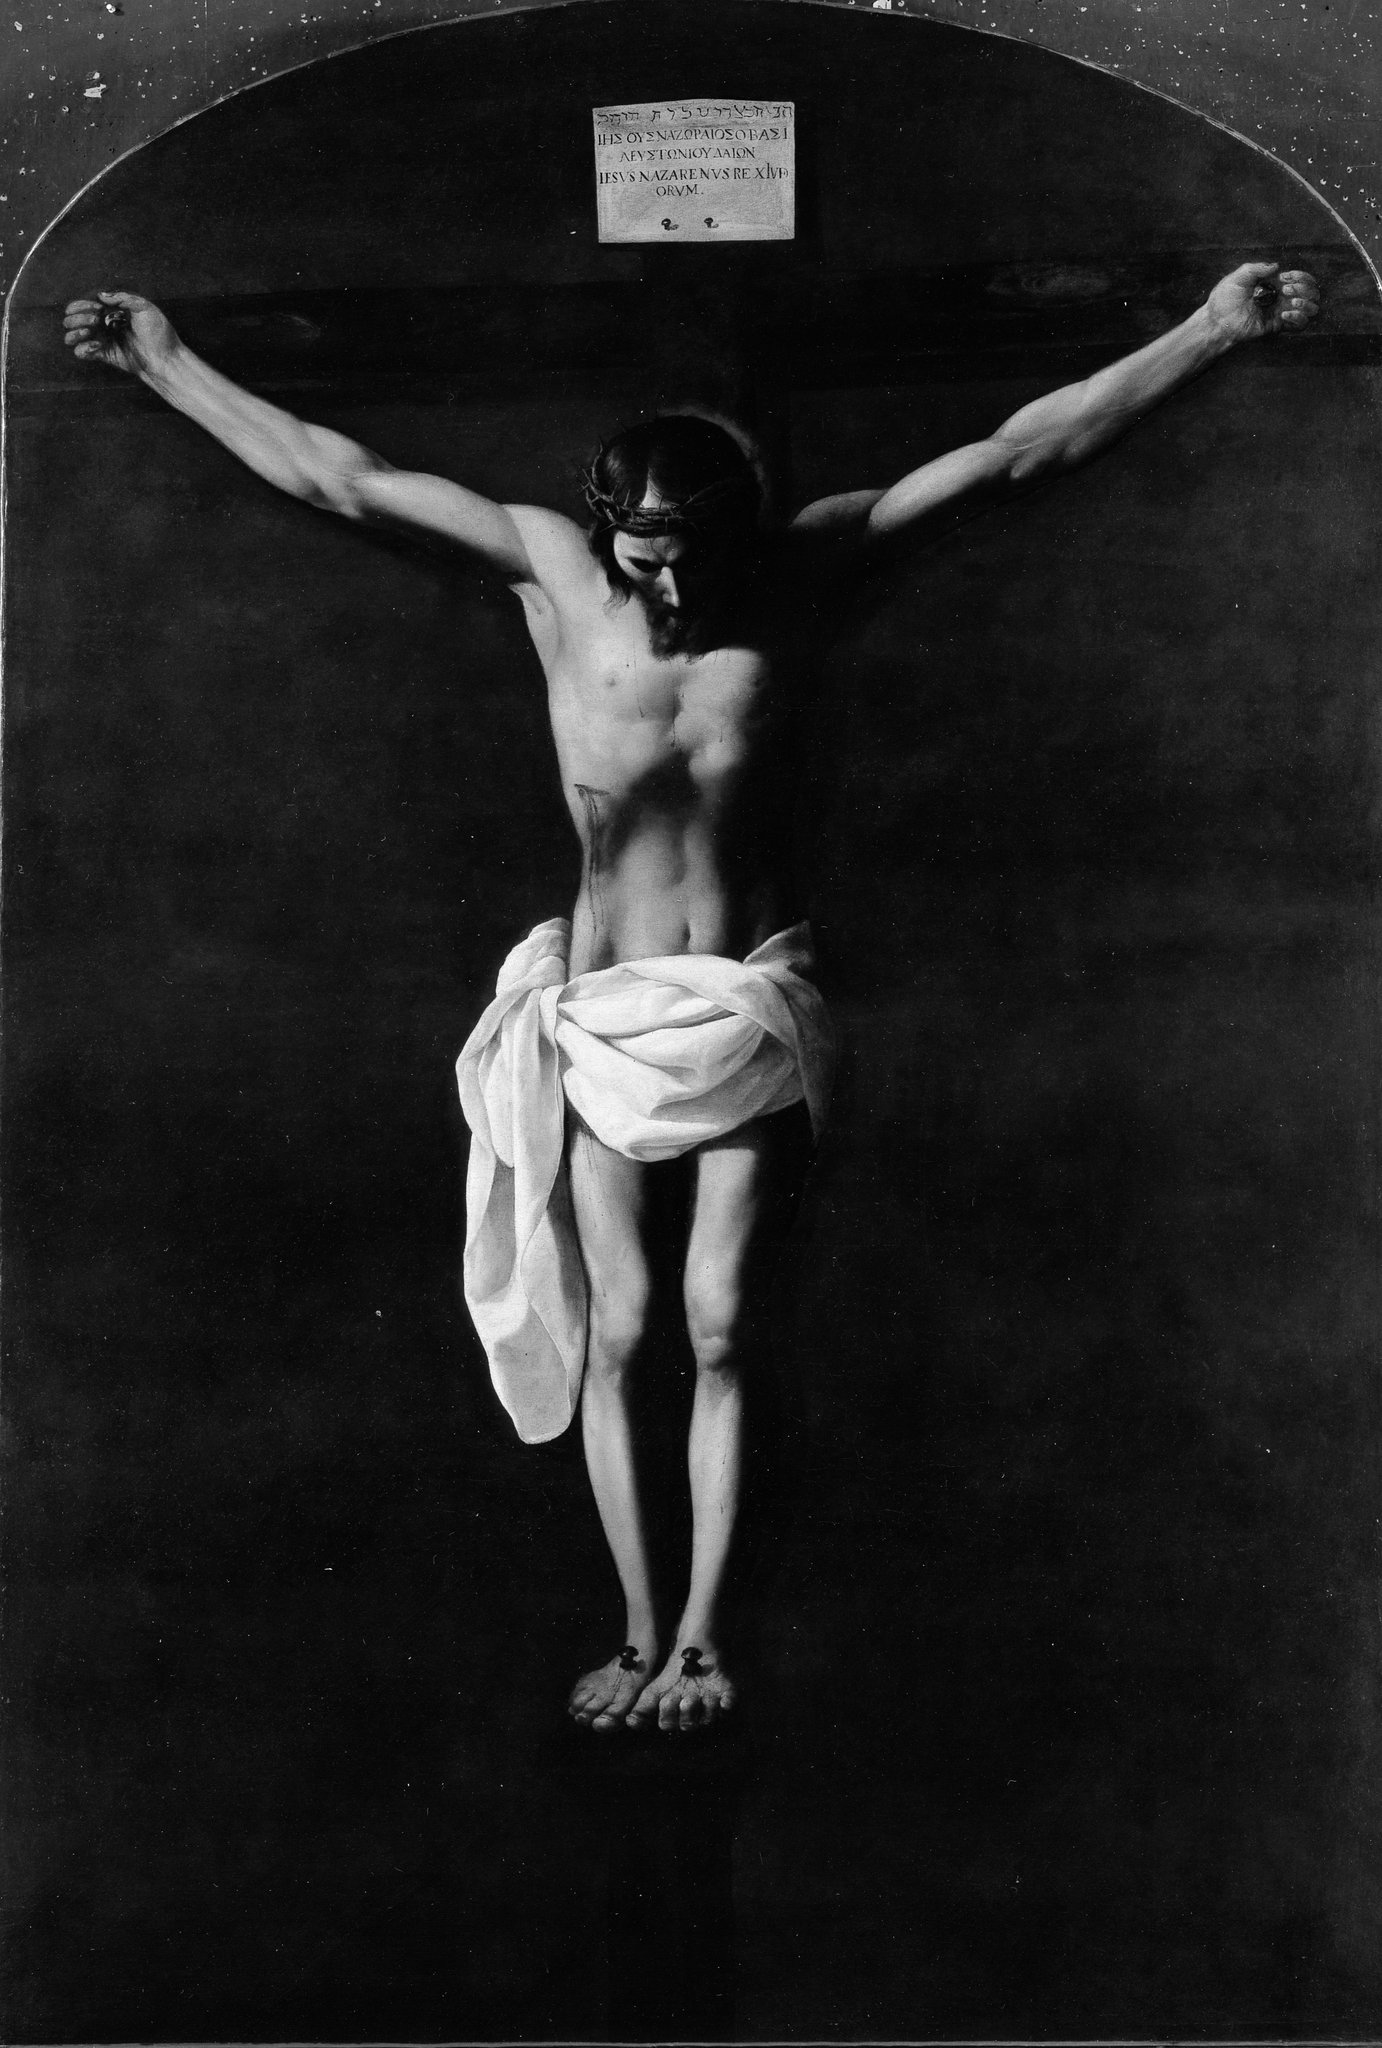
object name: painting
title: The Crucifixion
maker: francisco de zurbarán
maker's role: artist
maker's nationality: spanish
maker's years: 1598-1664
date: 1618-1664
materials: canvas, oil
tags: christ,crucifixion